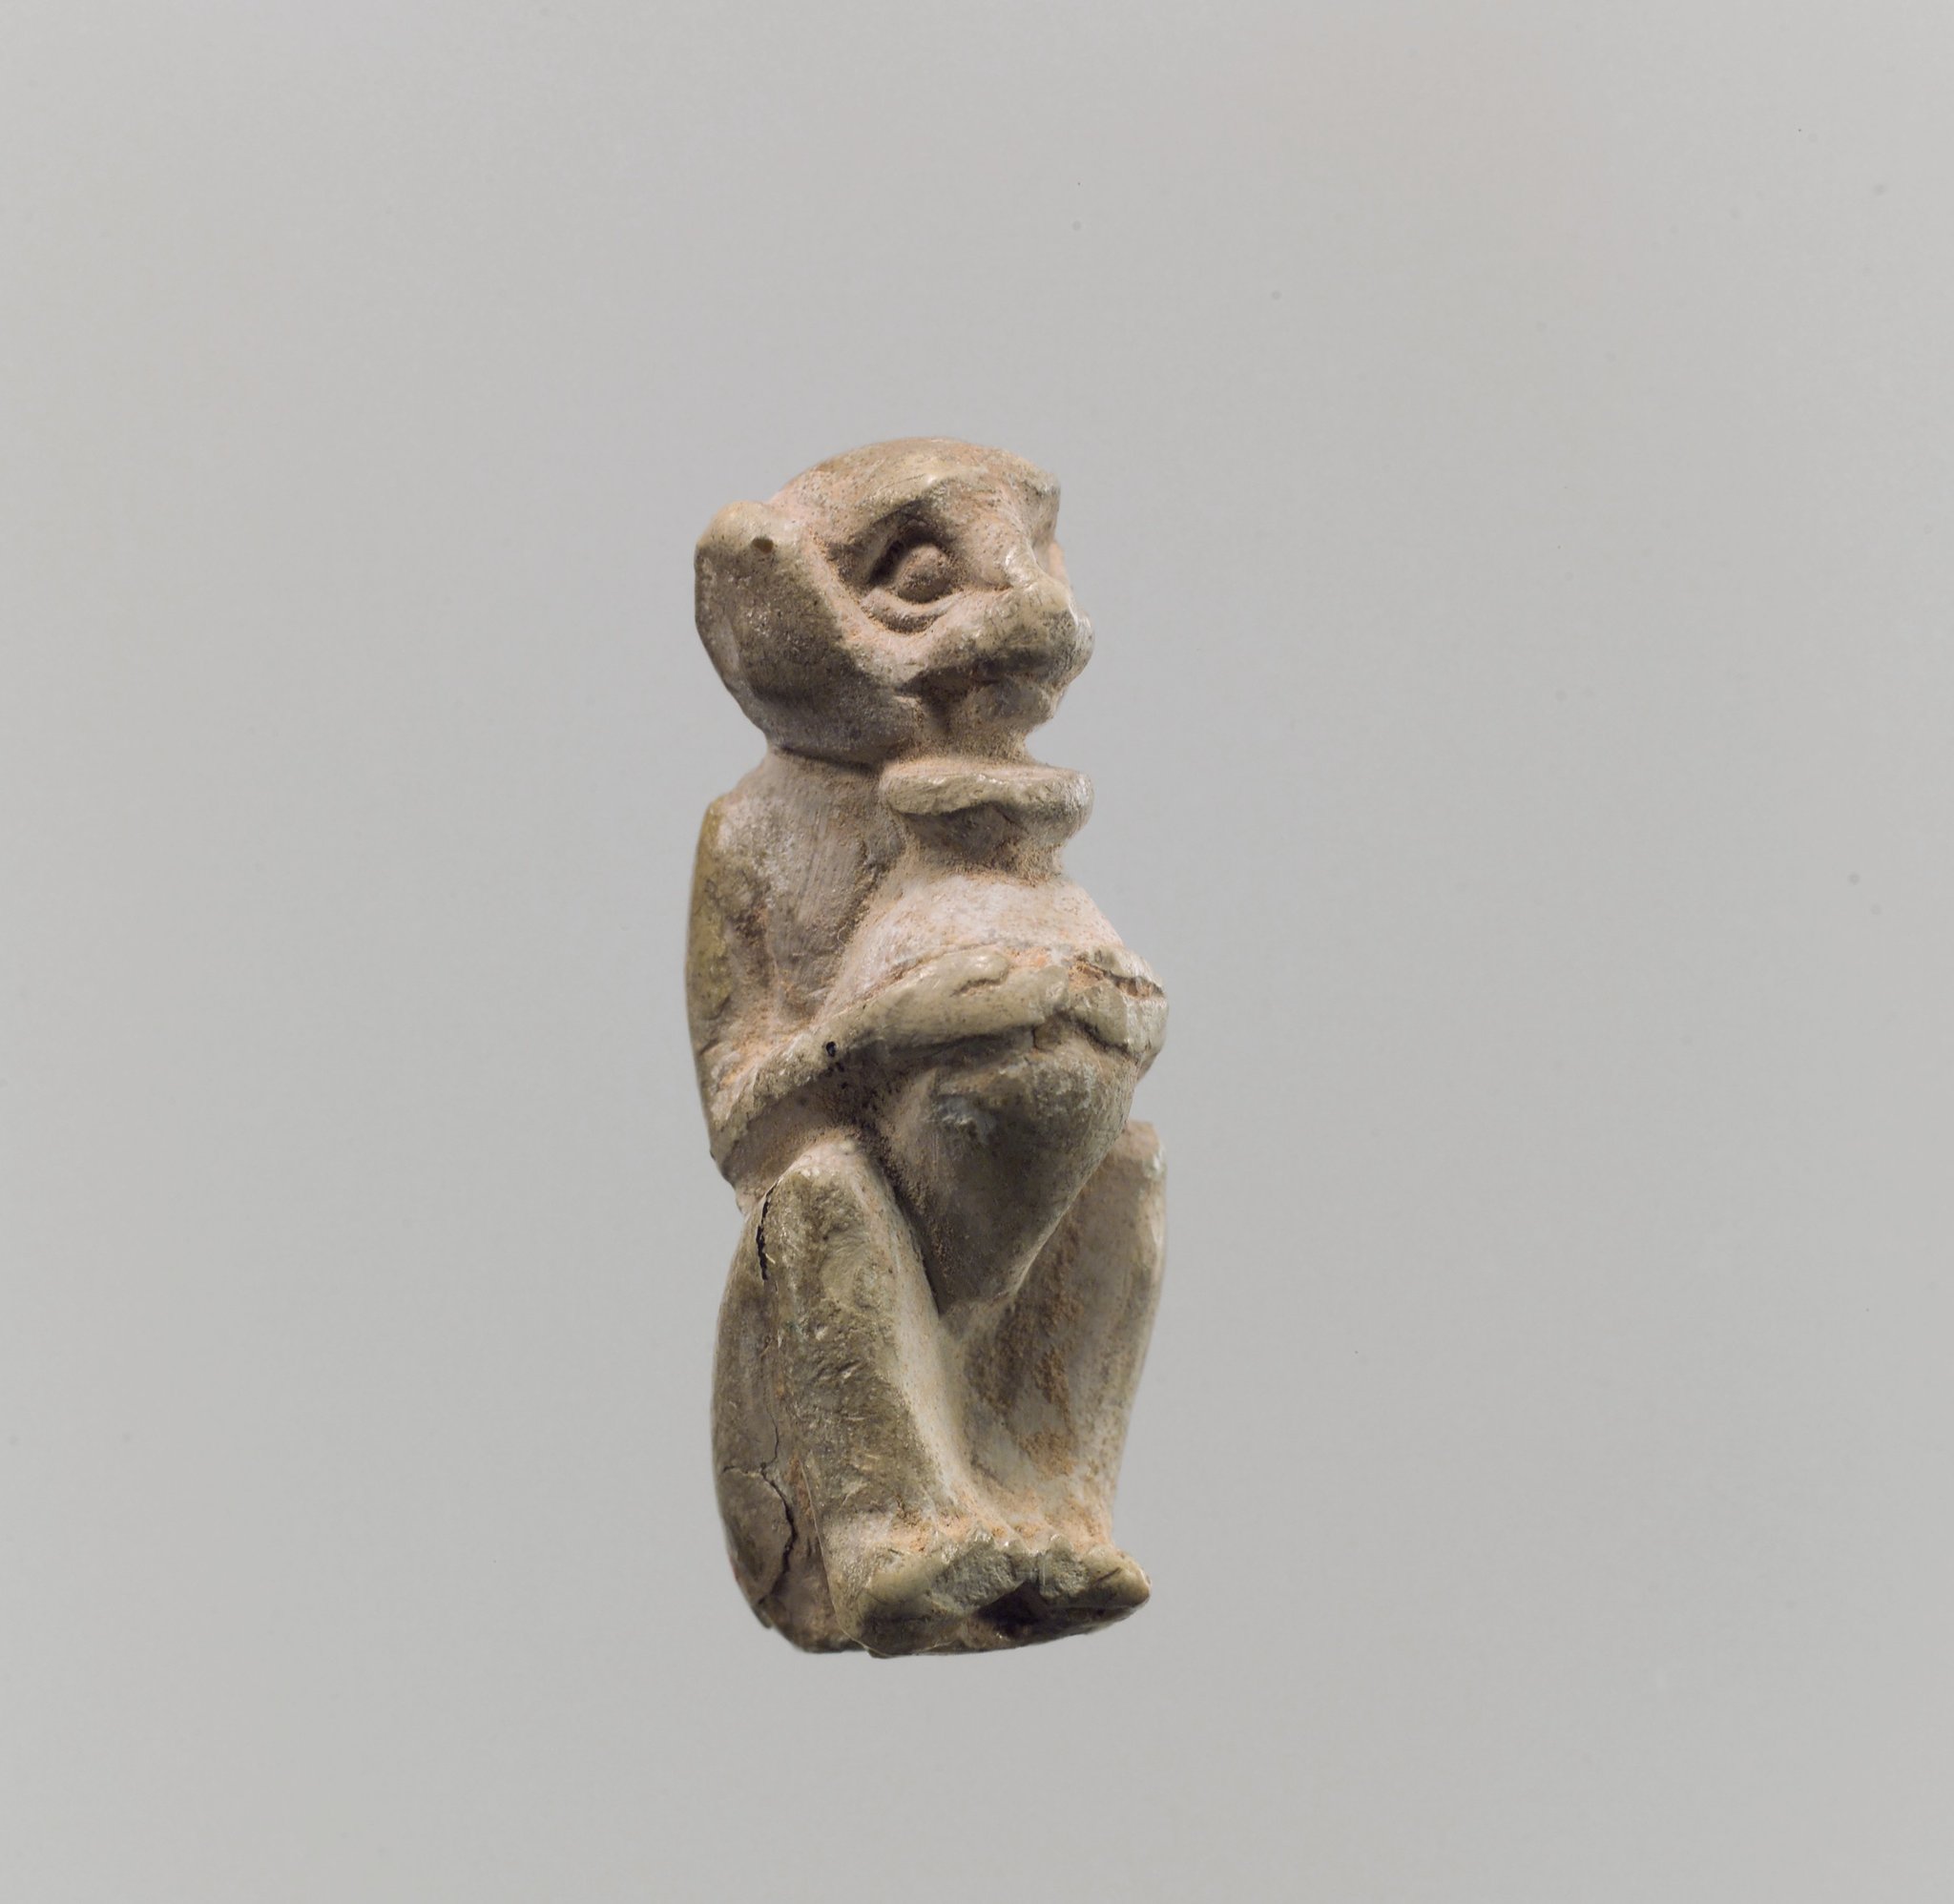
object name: sculpture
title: Monkey holding vessel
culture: assyrian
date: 1800-1701 BCE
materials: ivory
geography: anatolia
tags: monkeys